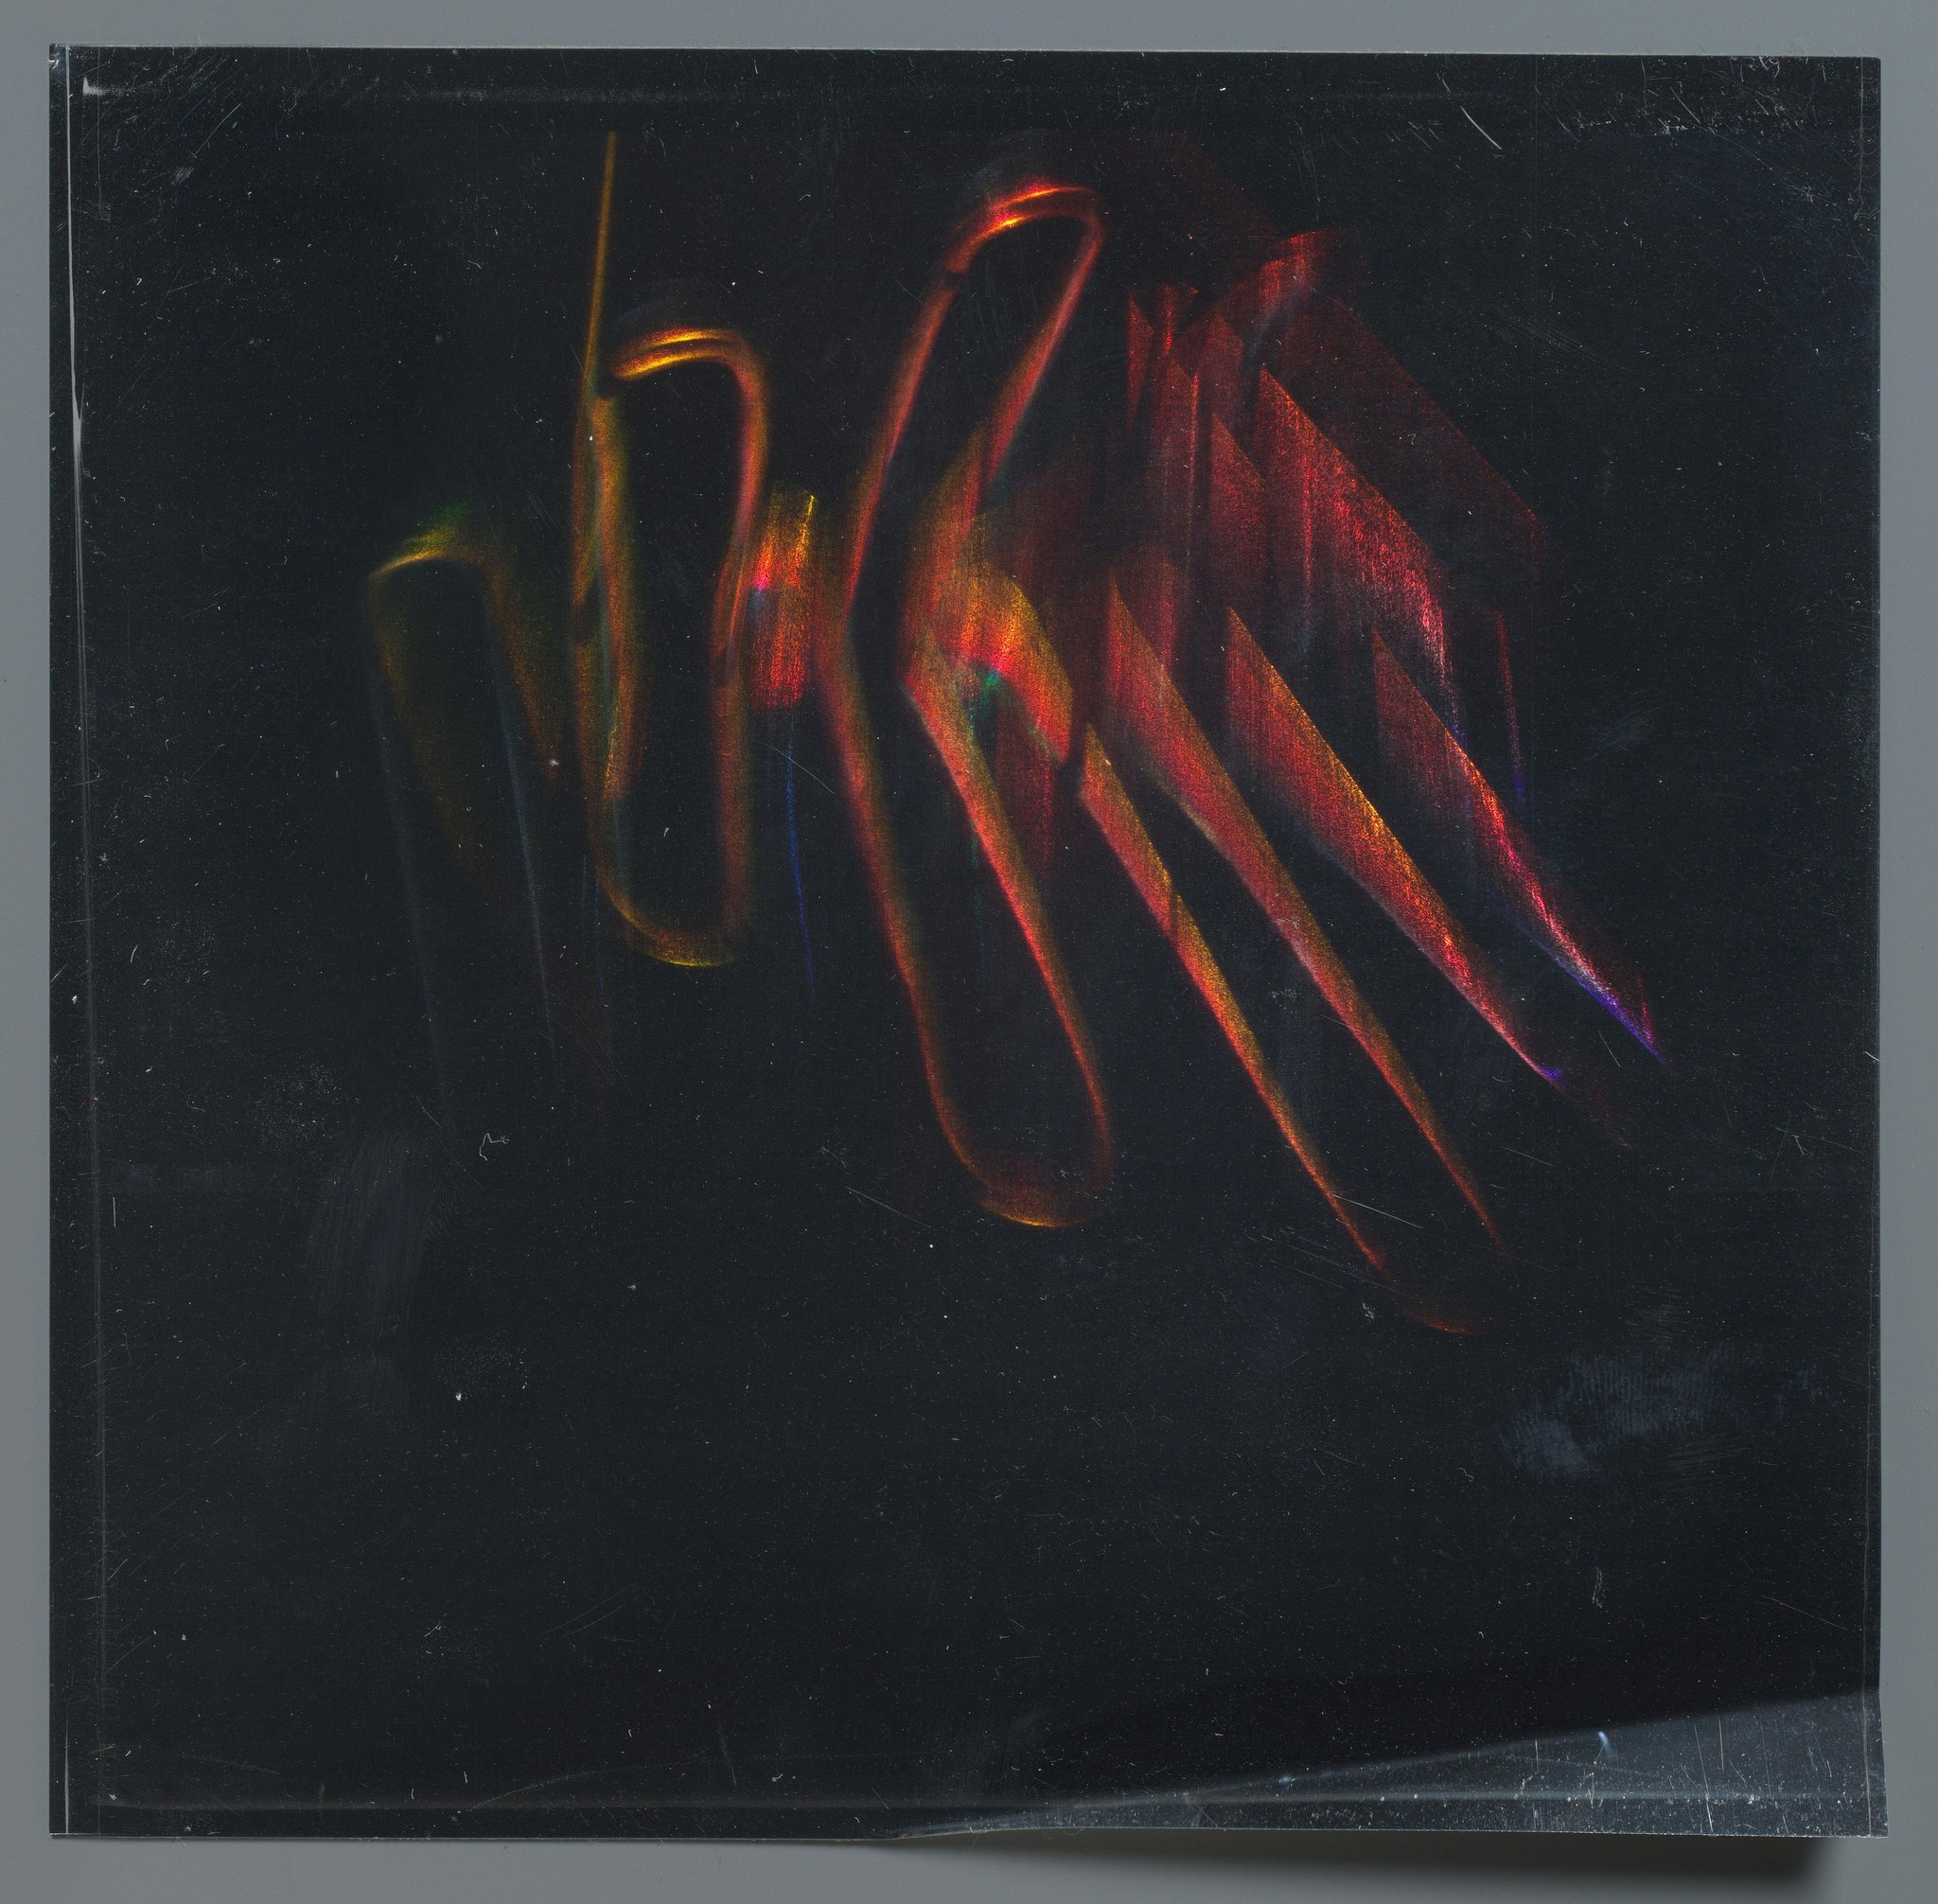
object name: hologram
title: Handen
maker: Anonymous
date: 1981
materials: plastic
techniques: photography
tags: hand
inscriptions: inscription: ‘gekocht dec 1981/ Hologram Galery/ Prinsengracht t/o Paleis/ van Justitie/ f 47.50/ [...] procedé/ mogelijk de aanloop tot/ opnemen holograms in/ boeken/ (embossed)’